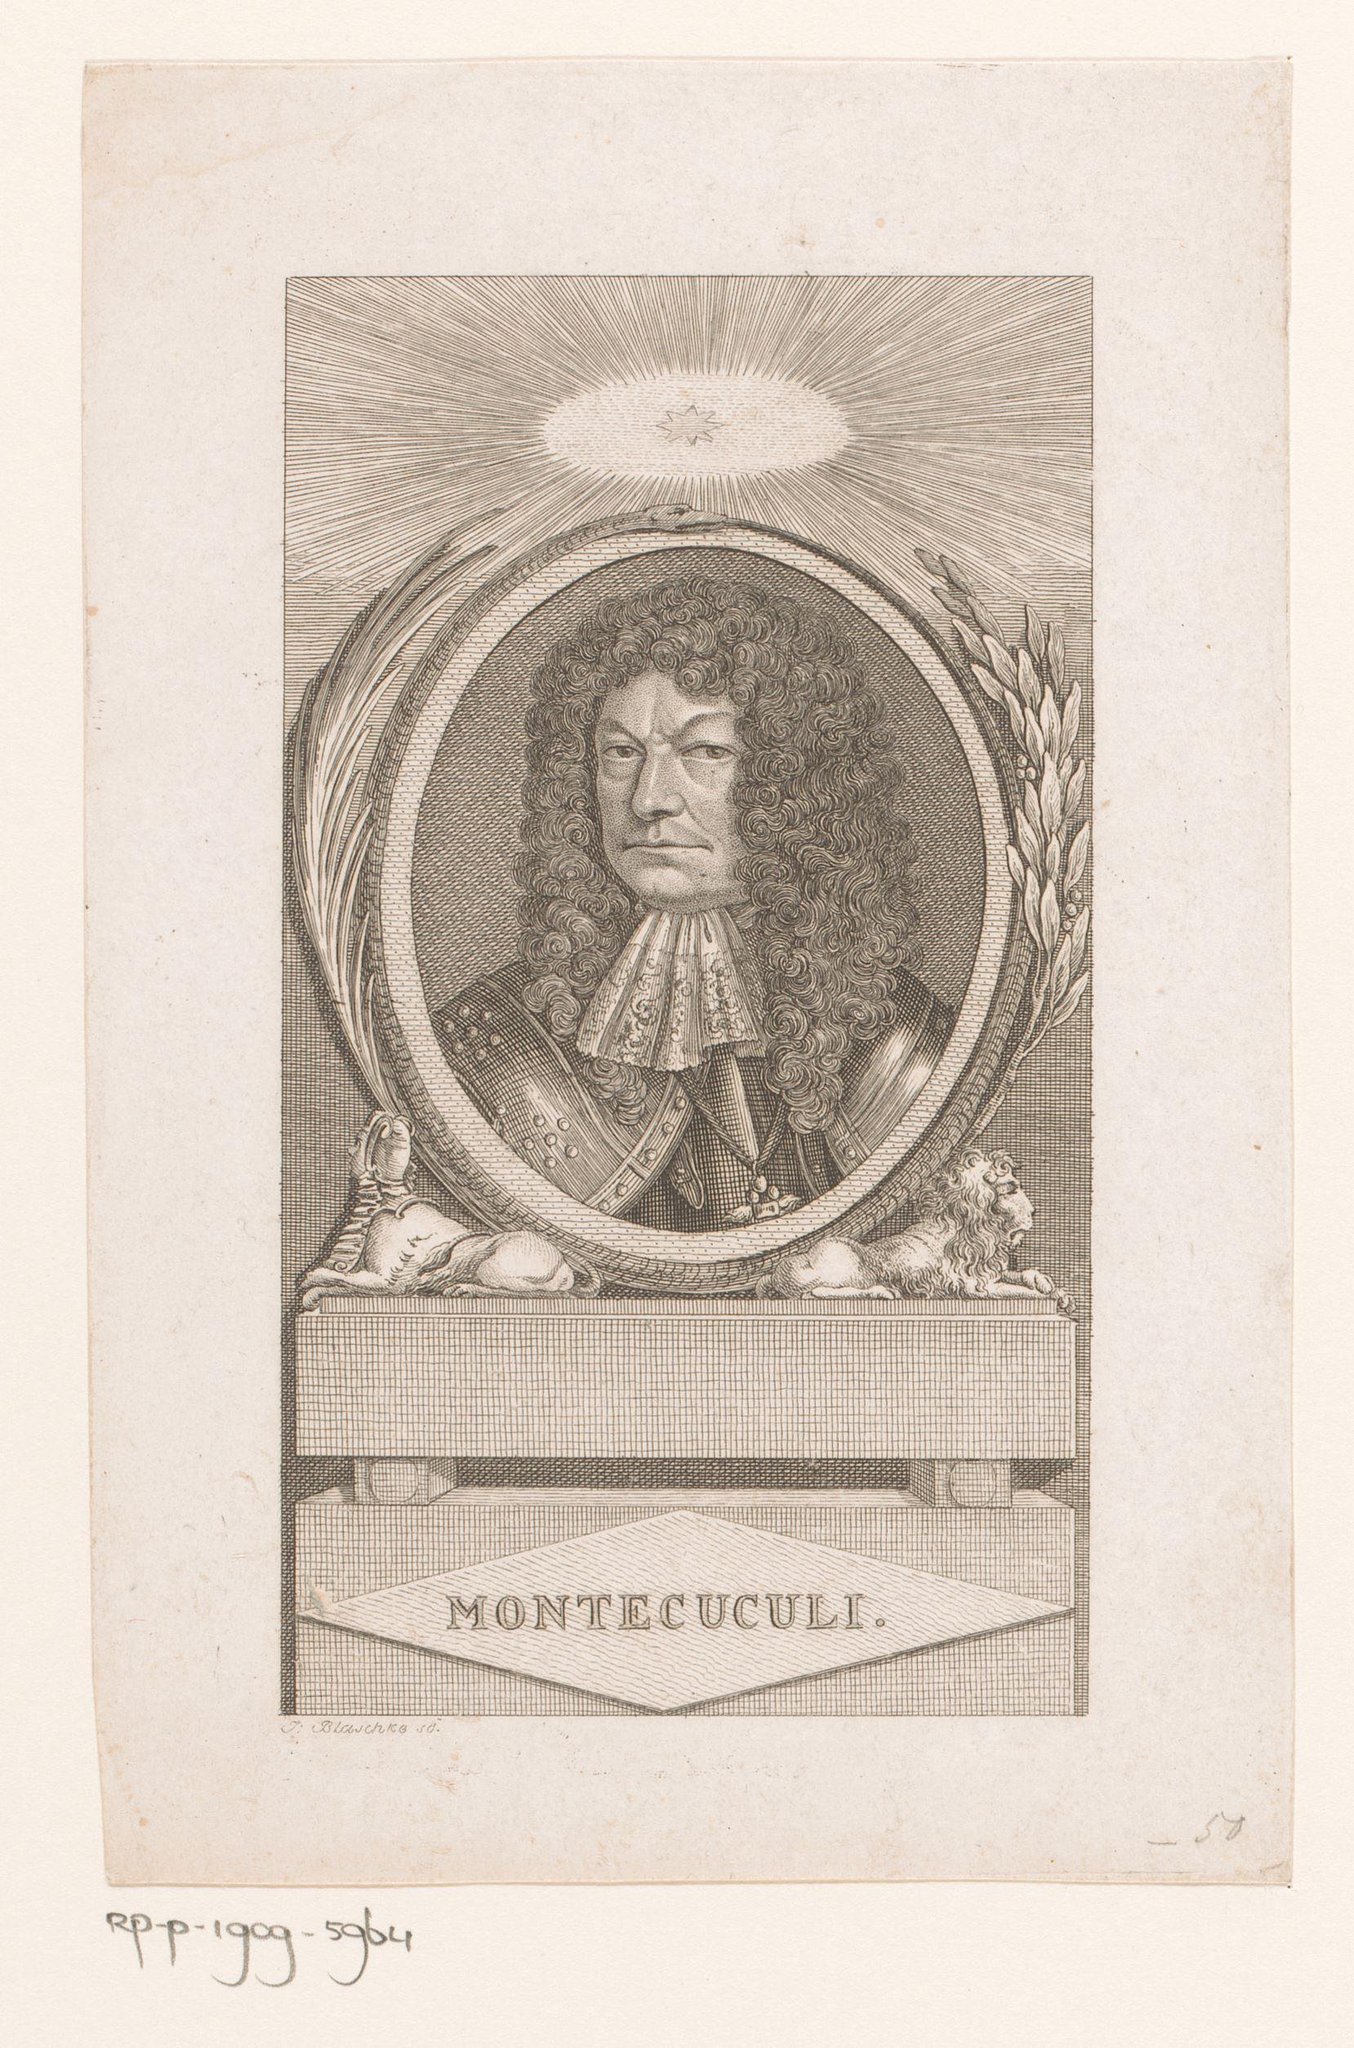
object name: book illustration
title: Portret van Raimondo Montecuccoli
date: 1808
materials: paper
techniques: etching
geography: vienna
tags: historical persons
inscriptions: collector's mark: Lugt 2228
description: Prent uit: Hormayr zu Hortenburg, Joseph freiherr von. Oesterreichischer Plutarch; oder Leben und Bildnisse aller Regenten und der berühmtesten Feldherren, Staatsmänner, Gelehrten und Künstler des österreichischen Kaiserstaates. 20 dln. Wenen: A. Doll, 1807-1815, dl. 14, p. 28.